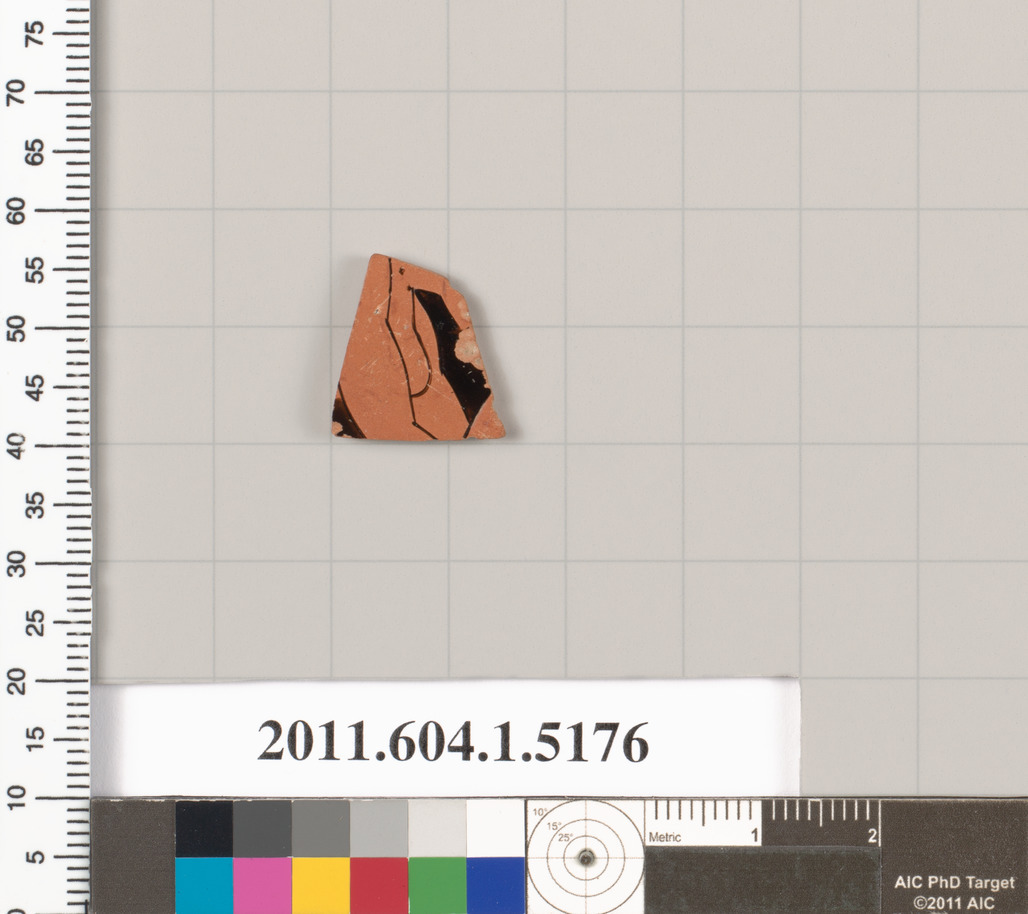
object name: kylix fragment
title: Terracotta fragment of a kylix (drinking cup)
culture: greek, attic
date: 500-480 BCE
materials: terracotta